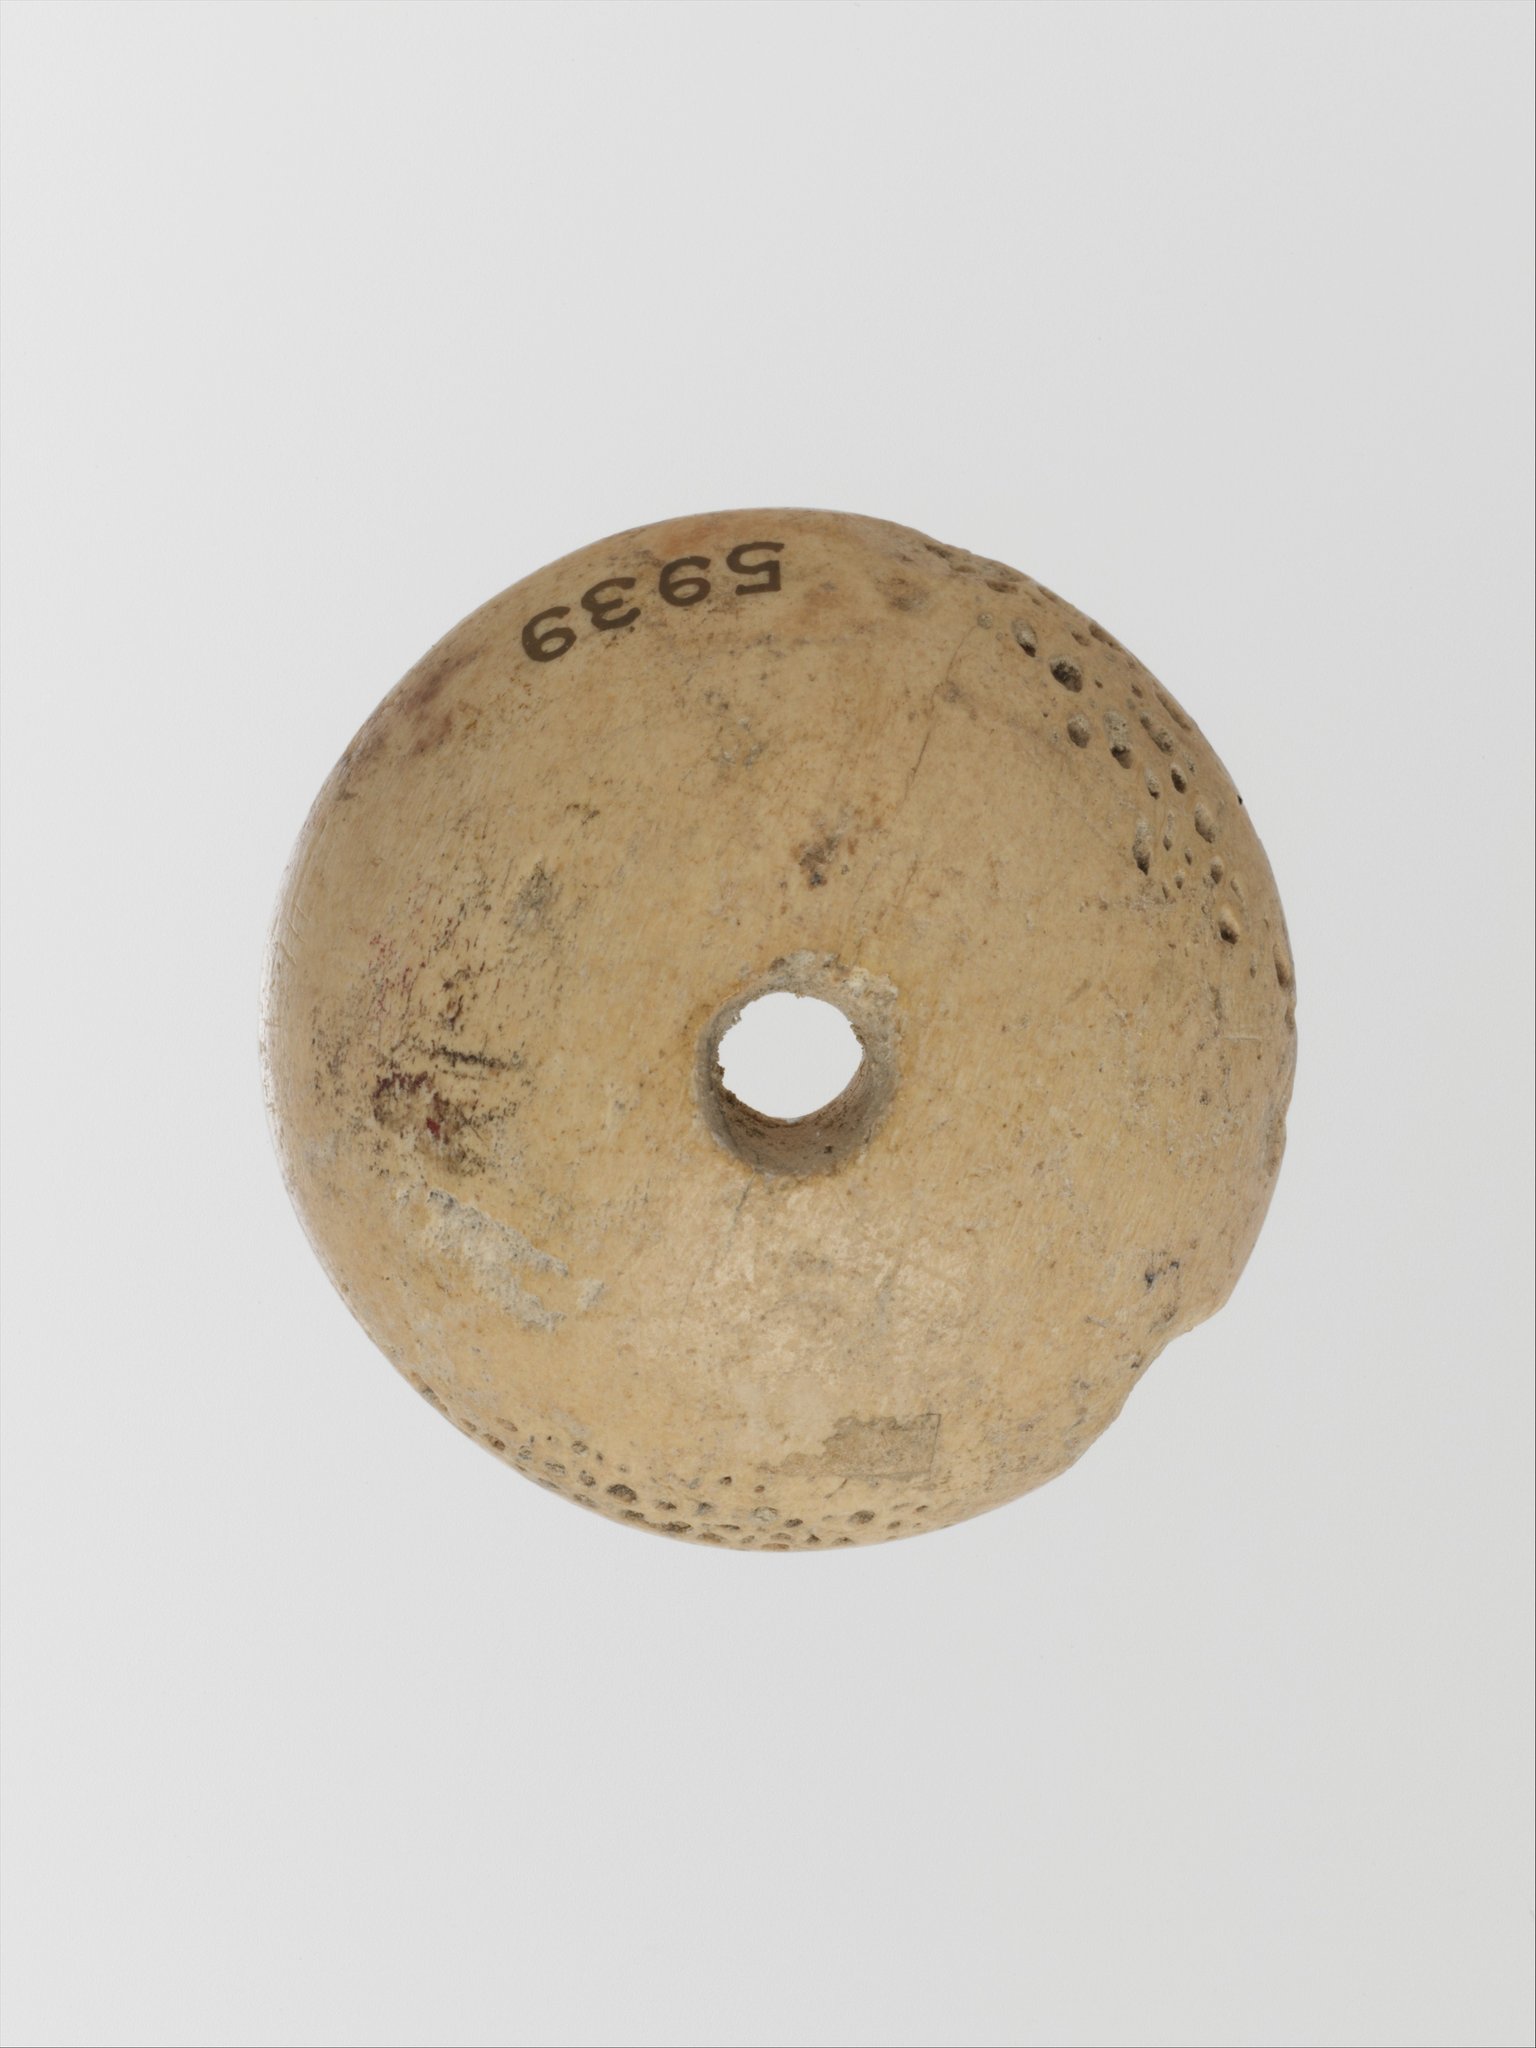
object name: whorl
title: Conical whorl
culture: cypriot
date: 1450-1050 BCE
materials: bone